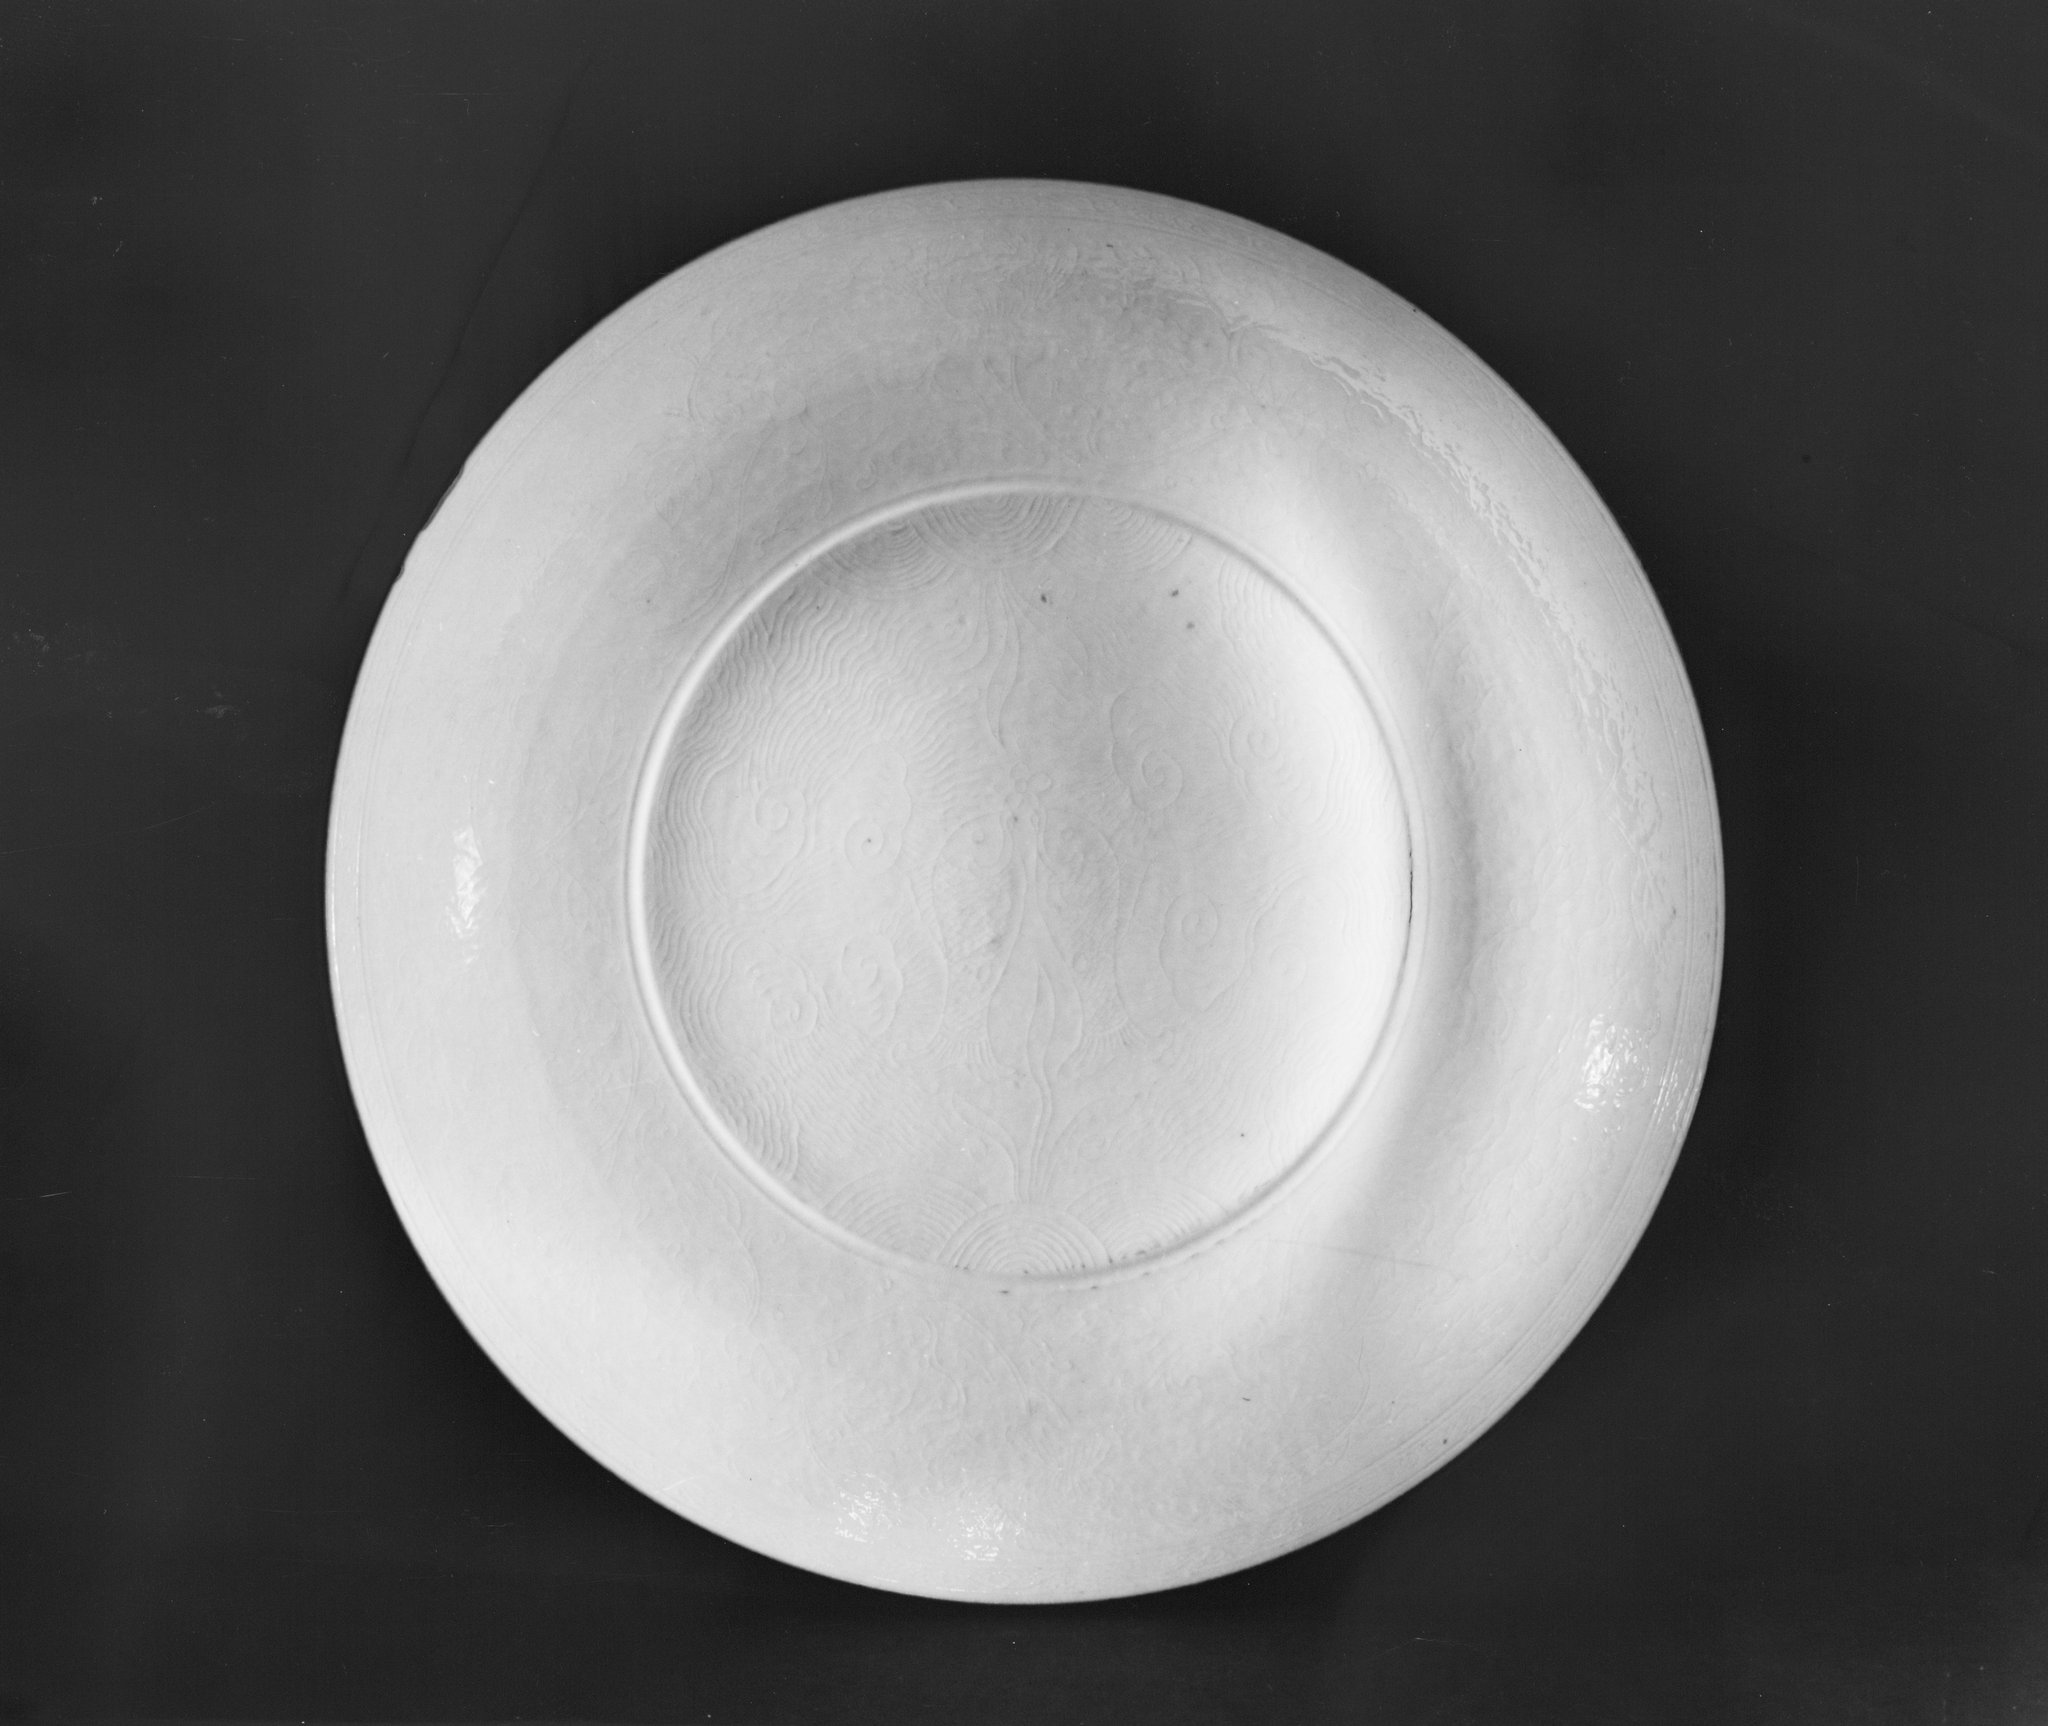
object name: plate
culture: chinese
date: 1721-1735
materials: porcelain